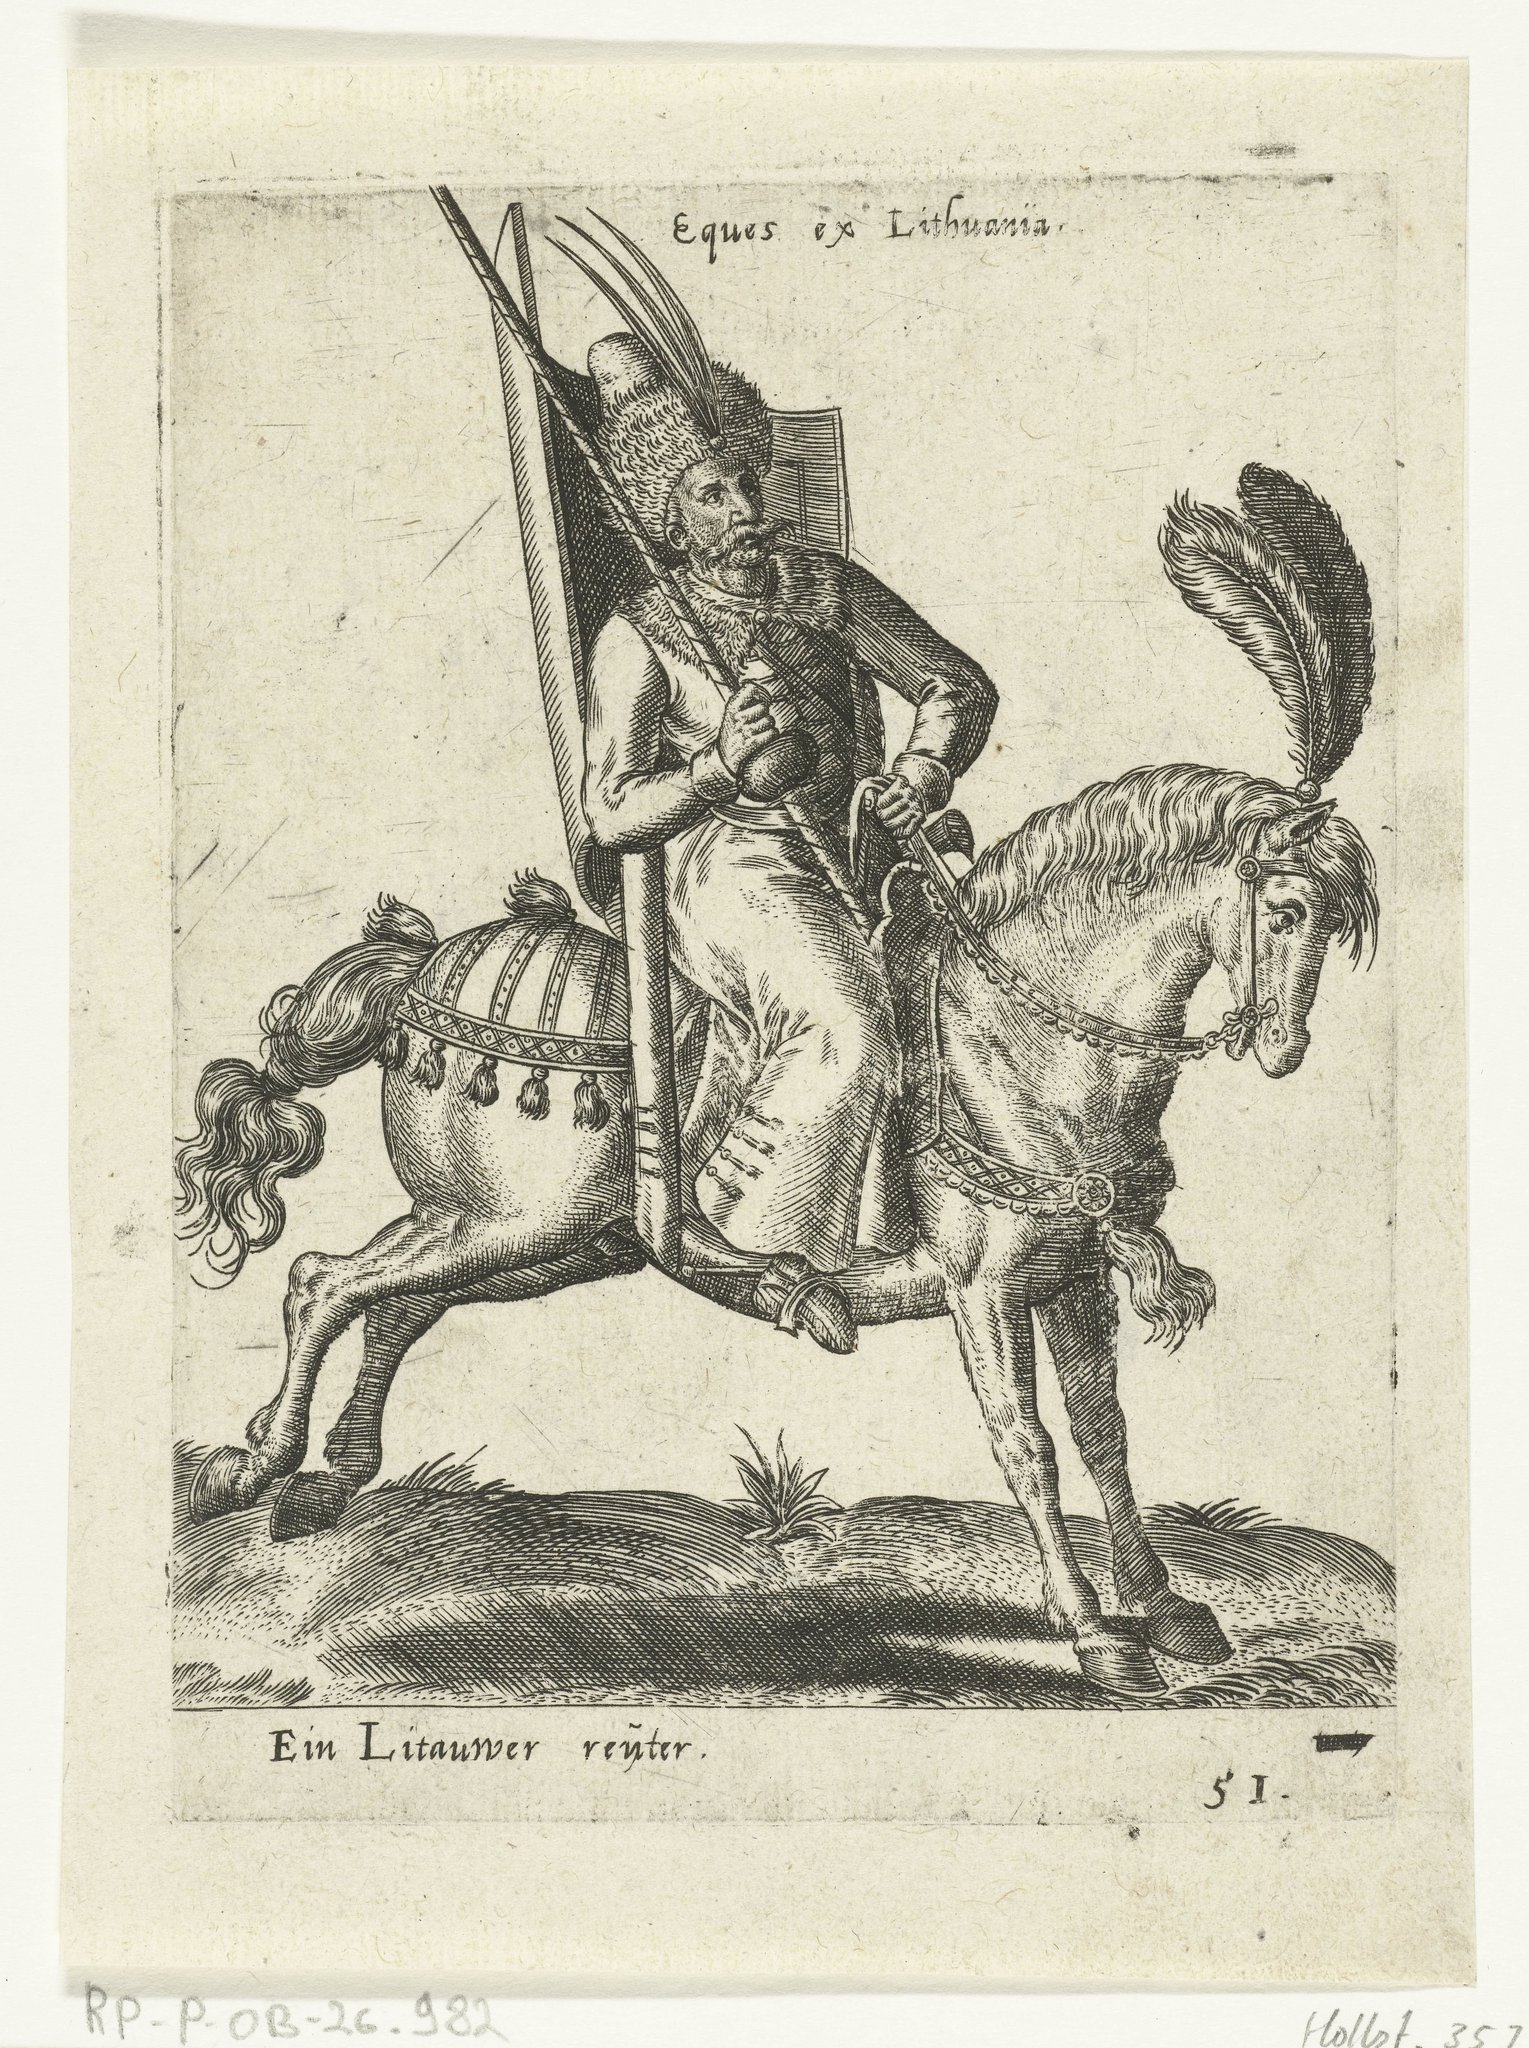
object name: costume print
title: Litouwse ruiter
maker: abraham de bruyn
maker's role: print maker, publisher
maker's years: 1540-1587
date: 1577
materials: paper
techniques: engraving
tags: warfare; military affairs (+ cavalry, horsemen), folk costume, regional costume, (military) uniforms, europeans (with name)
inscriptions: collector's mark: Lugt 2228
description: Prent oorspronkelijk verschenen in 'Equitum descripcio, quomodo equestres copie, nostra hac aetate, in sua armatura, per cunttas, videlicet Europae, Asiae et Affrice, nationes in re militare sese habent nunc primum', Keulen 1577.